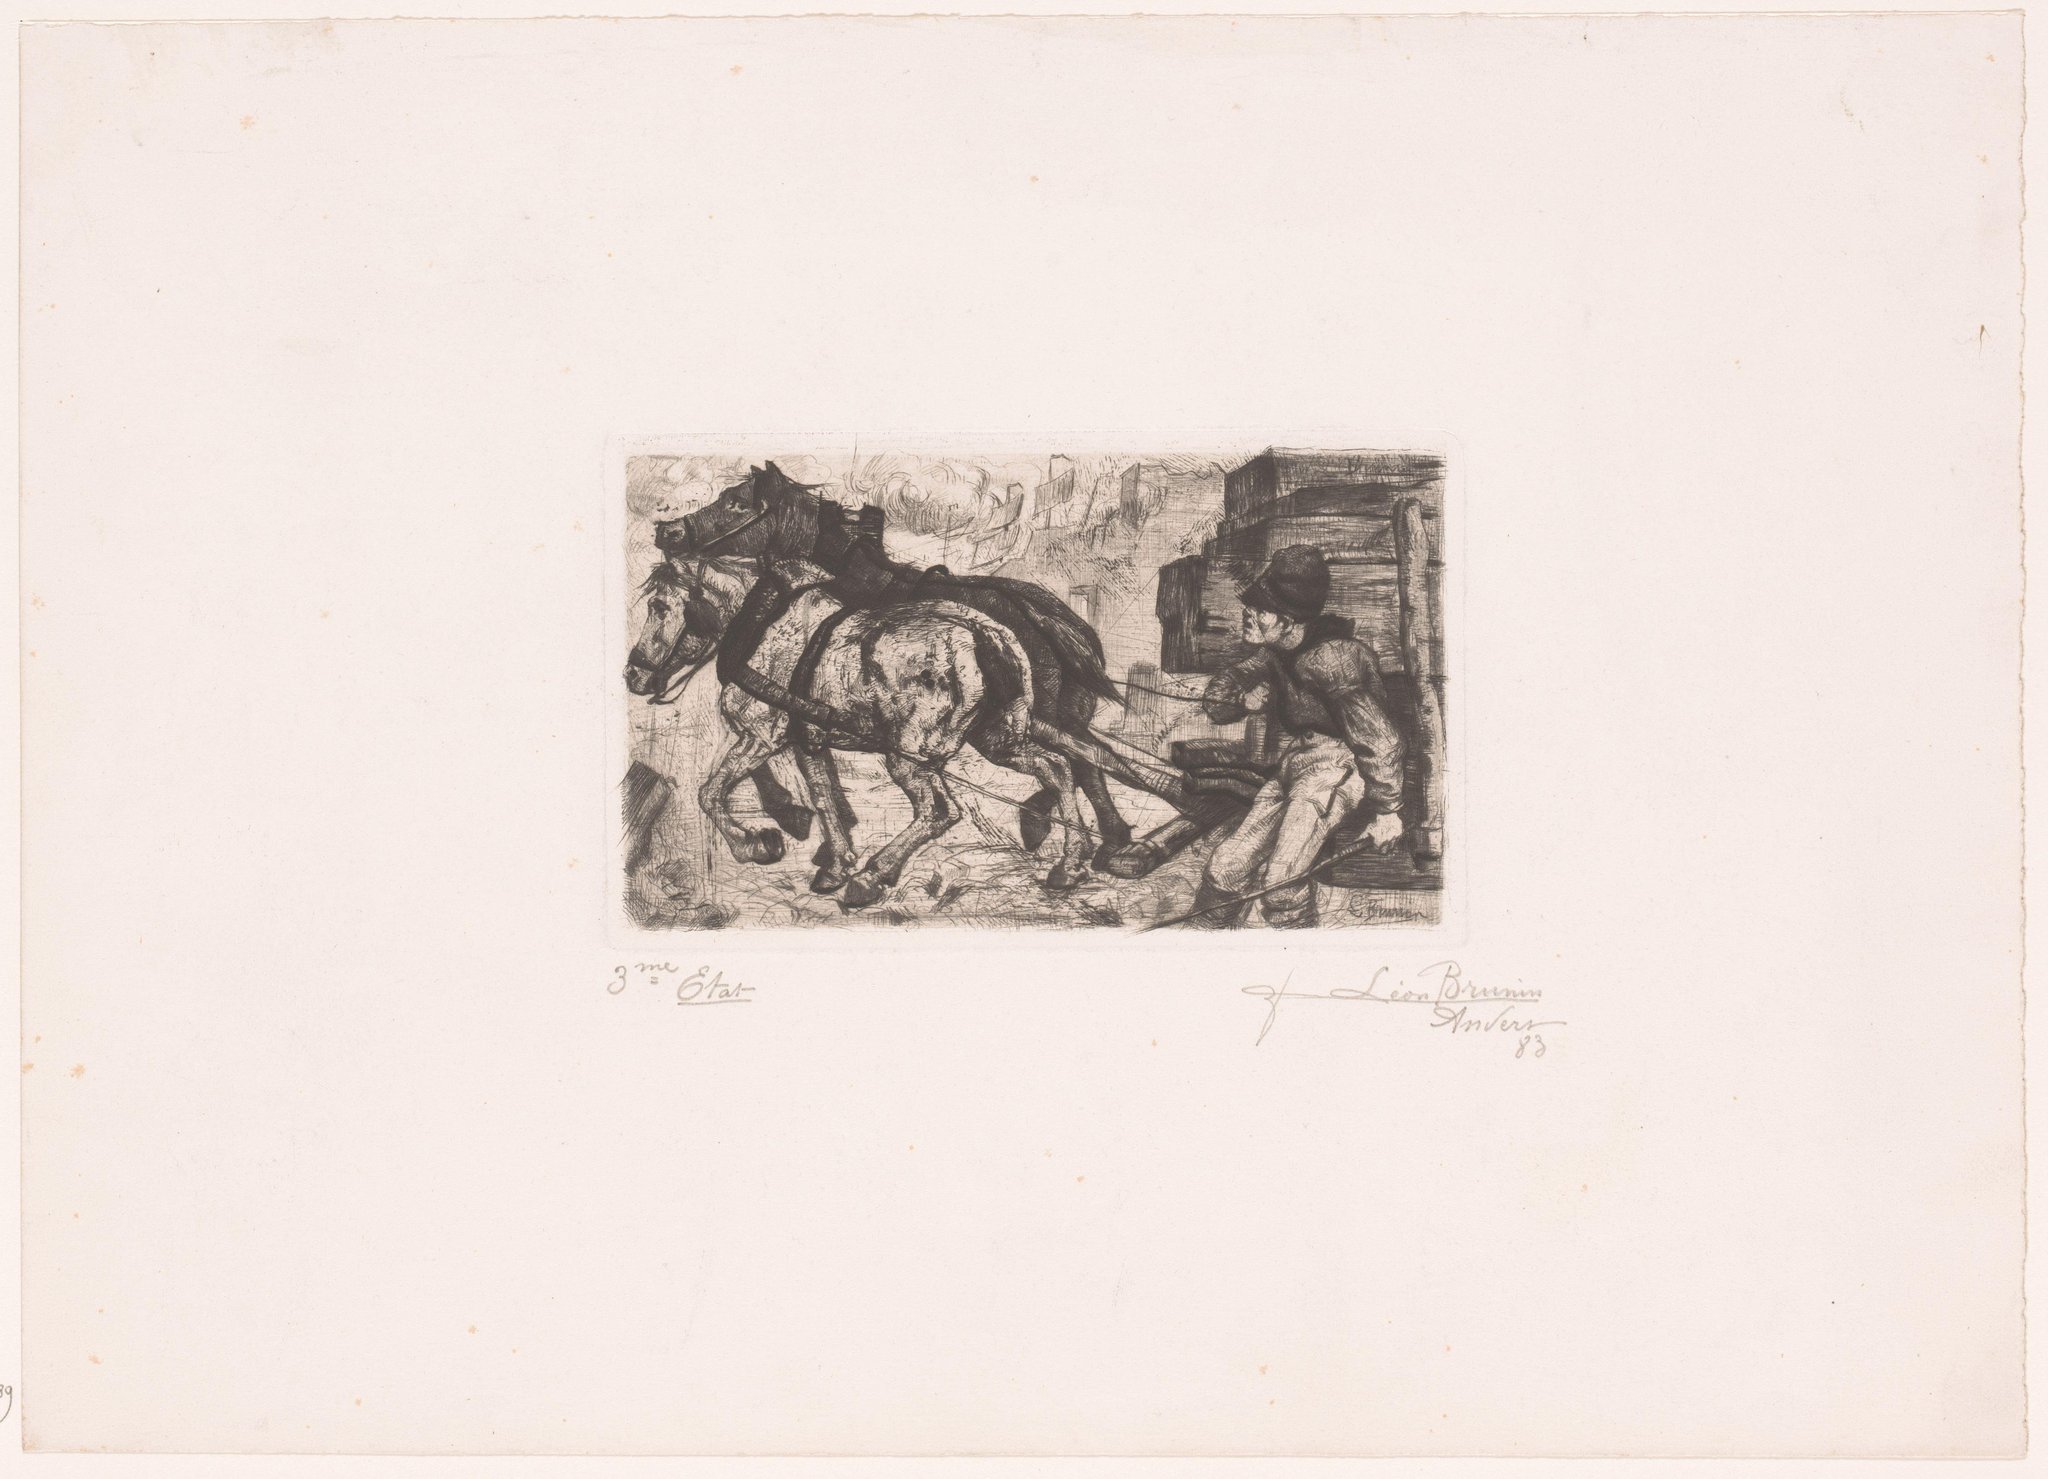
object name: print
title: Wagenmenner leidt een tweespan dat een zwaar beladen kar trekt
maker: léon brunin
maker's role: print maker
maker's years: 1861-1949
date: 1883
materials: paper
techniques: drypoint, etching, intaglio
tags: (farm) wagon, freight wagon, cart, whip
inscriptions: annotation: ‘3me Etat’